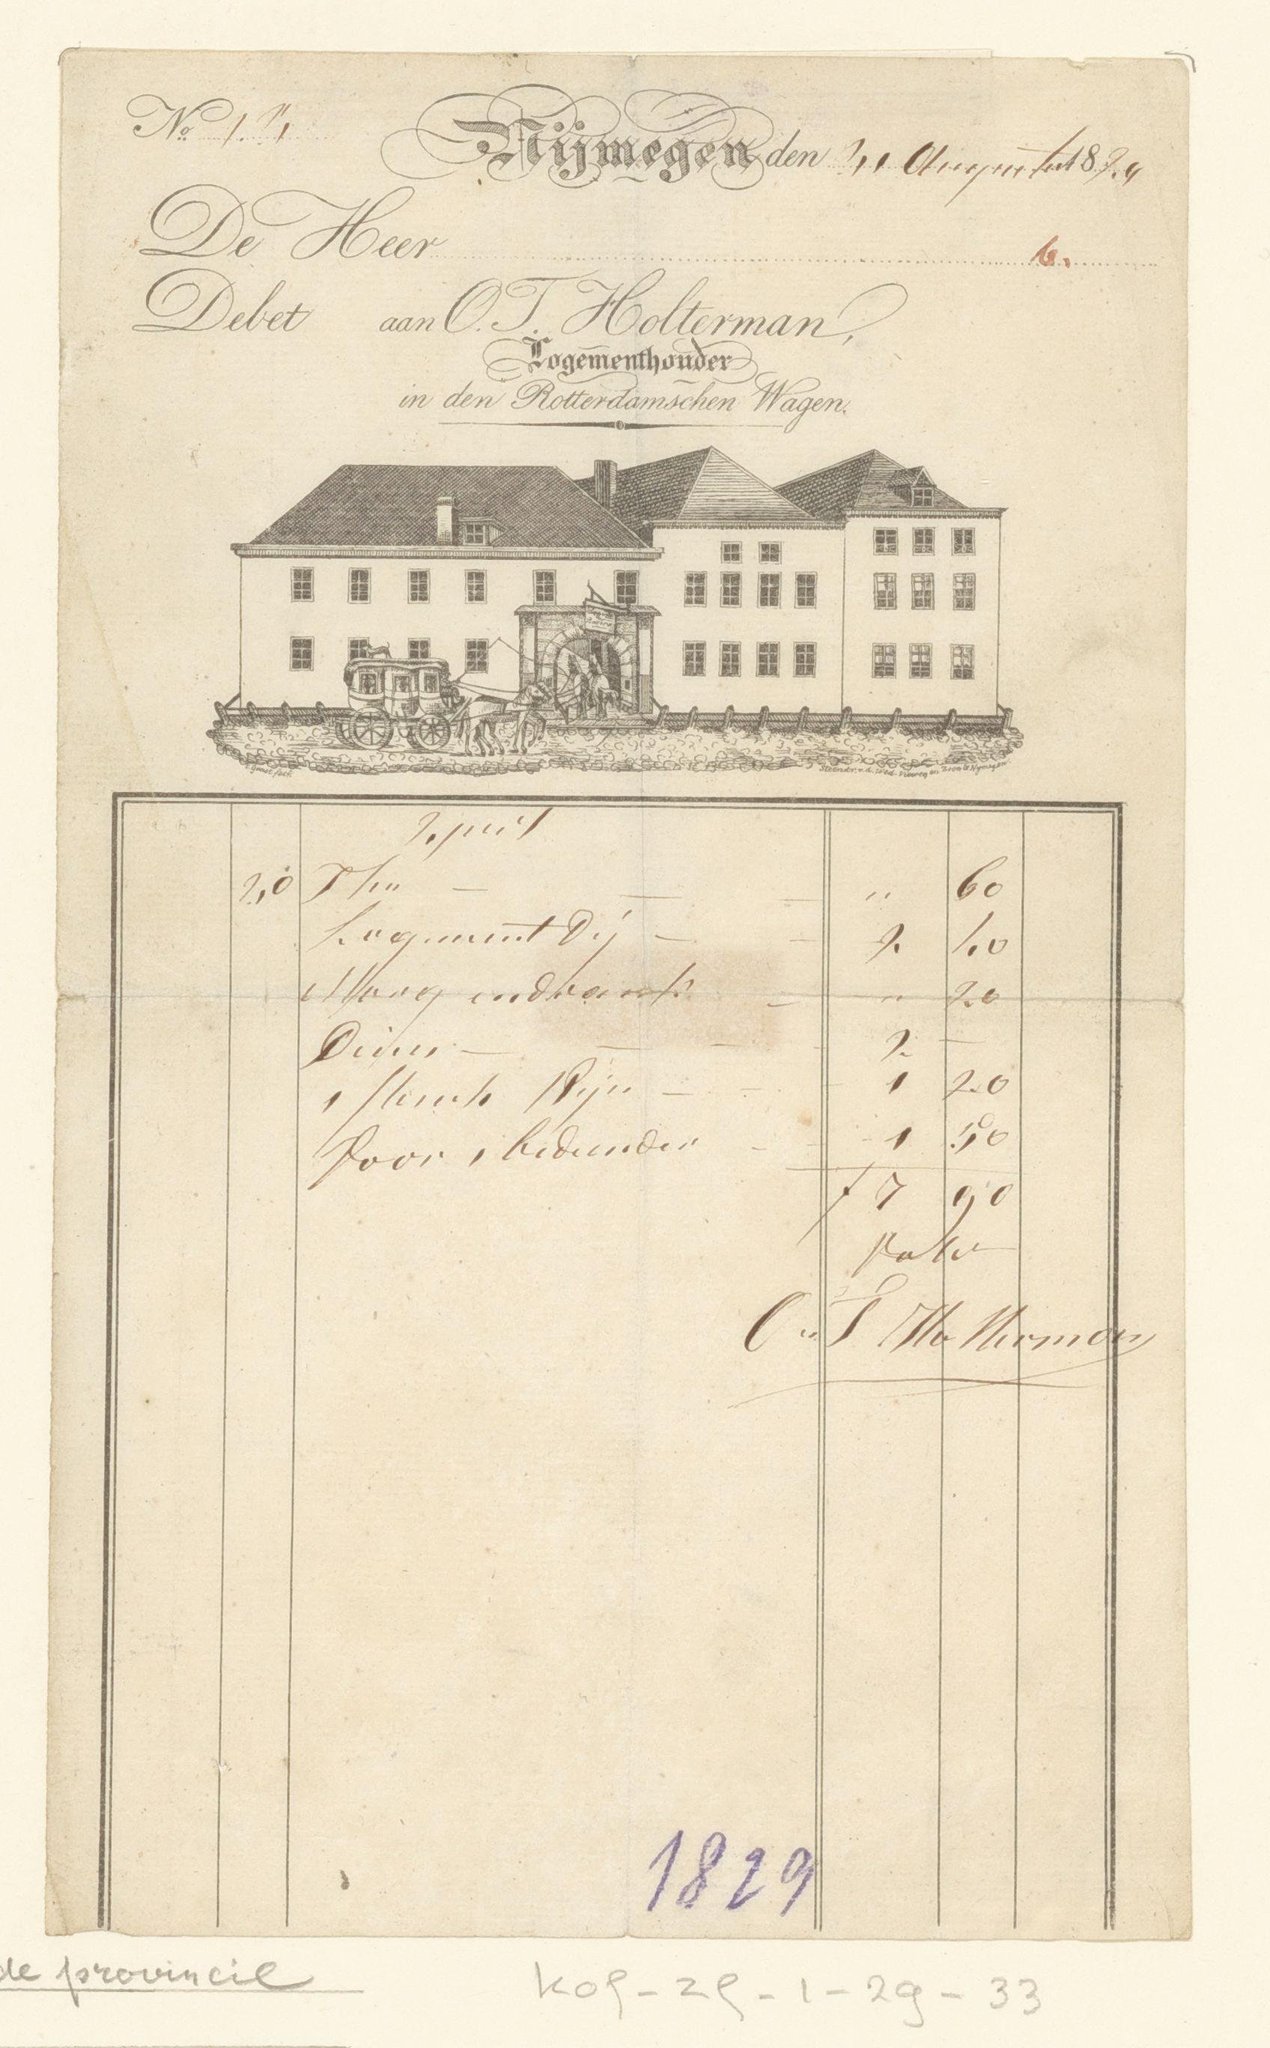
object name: account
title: Rekening voor het logement in den Rotterdamschen Wagen te Nijmegen, 1829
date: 1829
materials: ink, paper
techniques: lithograph, pen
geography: nijmegen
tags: hotel, hostelry, inn, nijmegen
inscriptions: stamp, collector's mark: Lugt 1641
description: Rekening voor het logement in den Rotterdamschen Wagen te Nijmegen, 1829. Op de rekening staan de kosten voor kamers, het diner, een fles wijn en de bediening. Onderwerpsrubrieken binnen de Atlas Zeden en Gewoonten: Zeden en gewoonten in engeren zin, Volksleven, Uitspanningslokalen, Logementen.